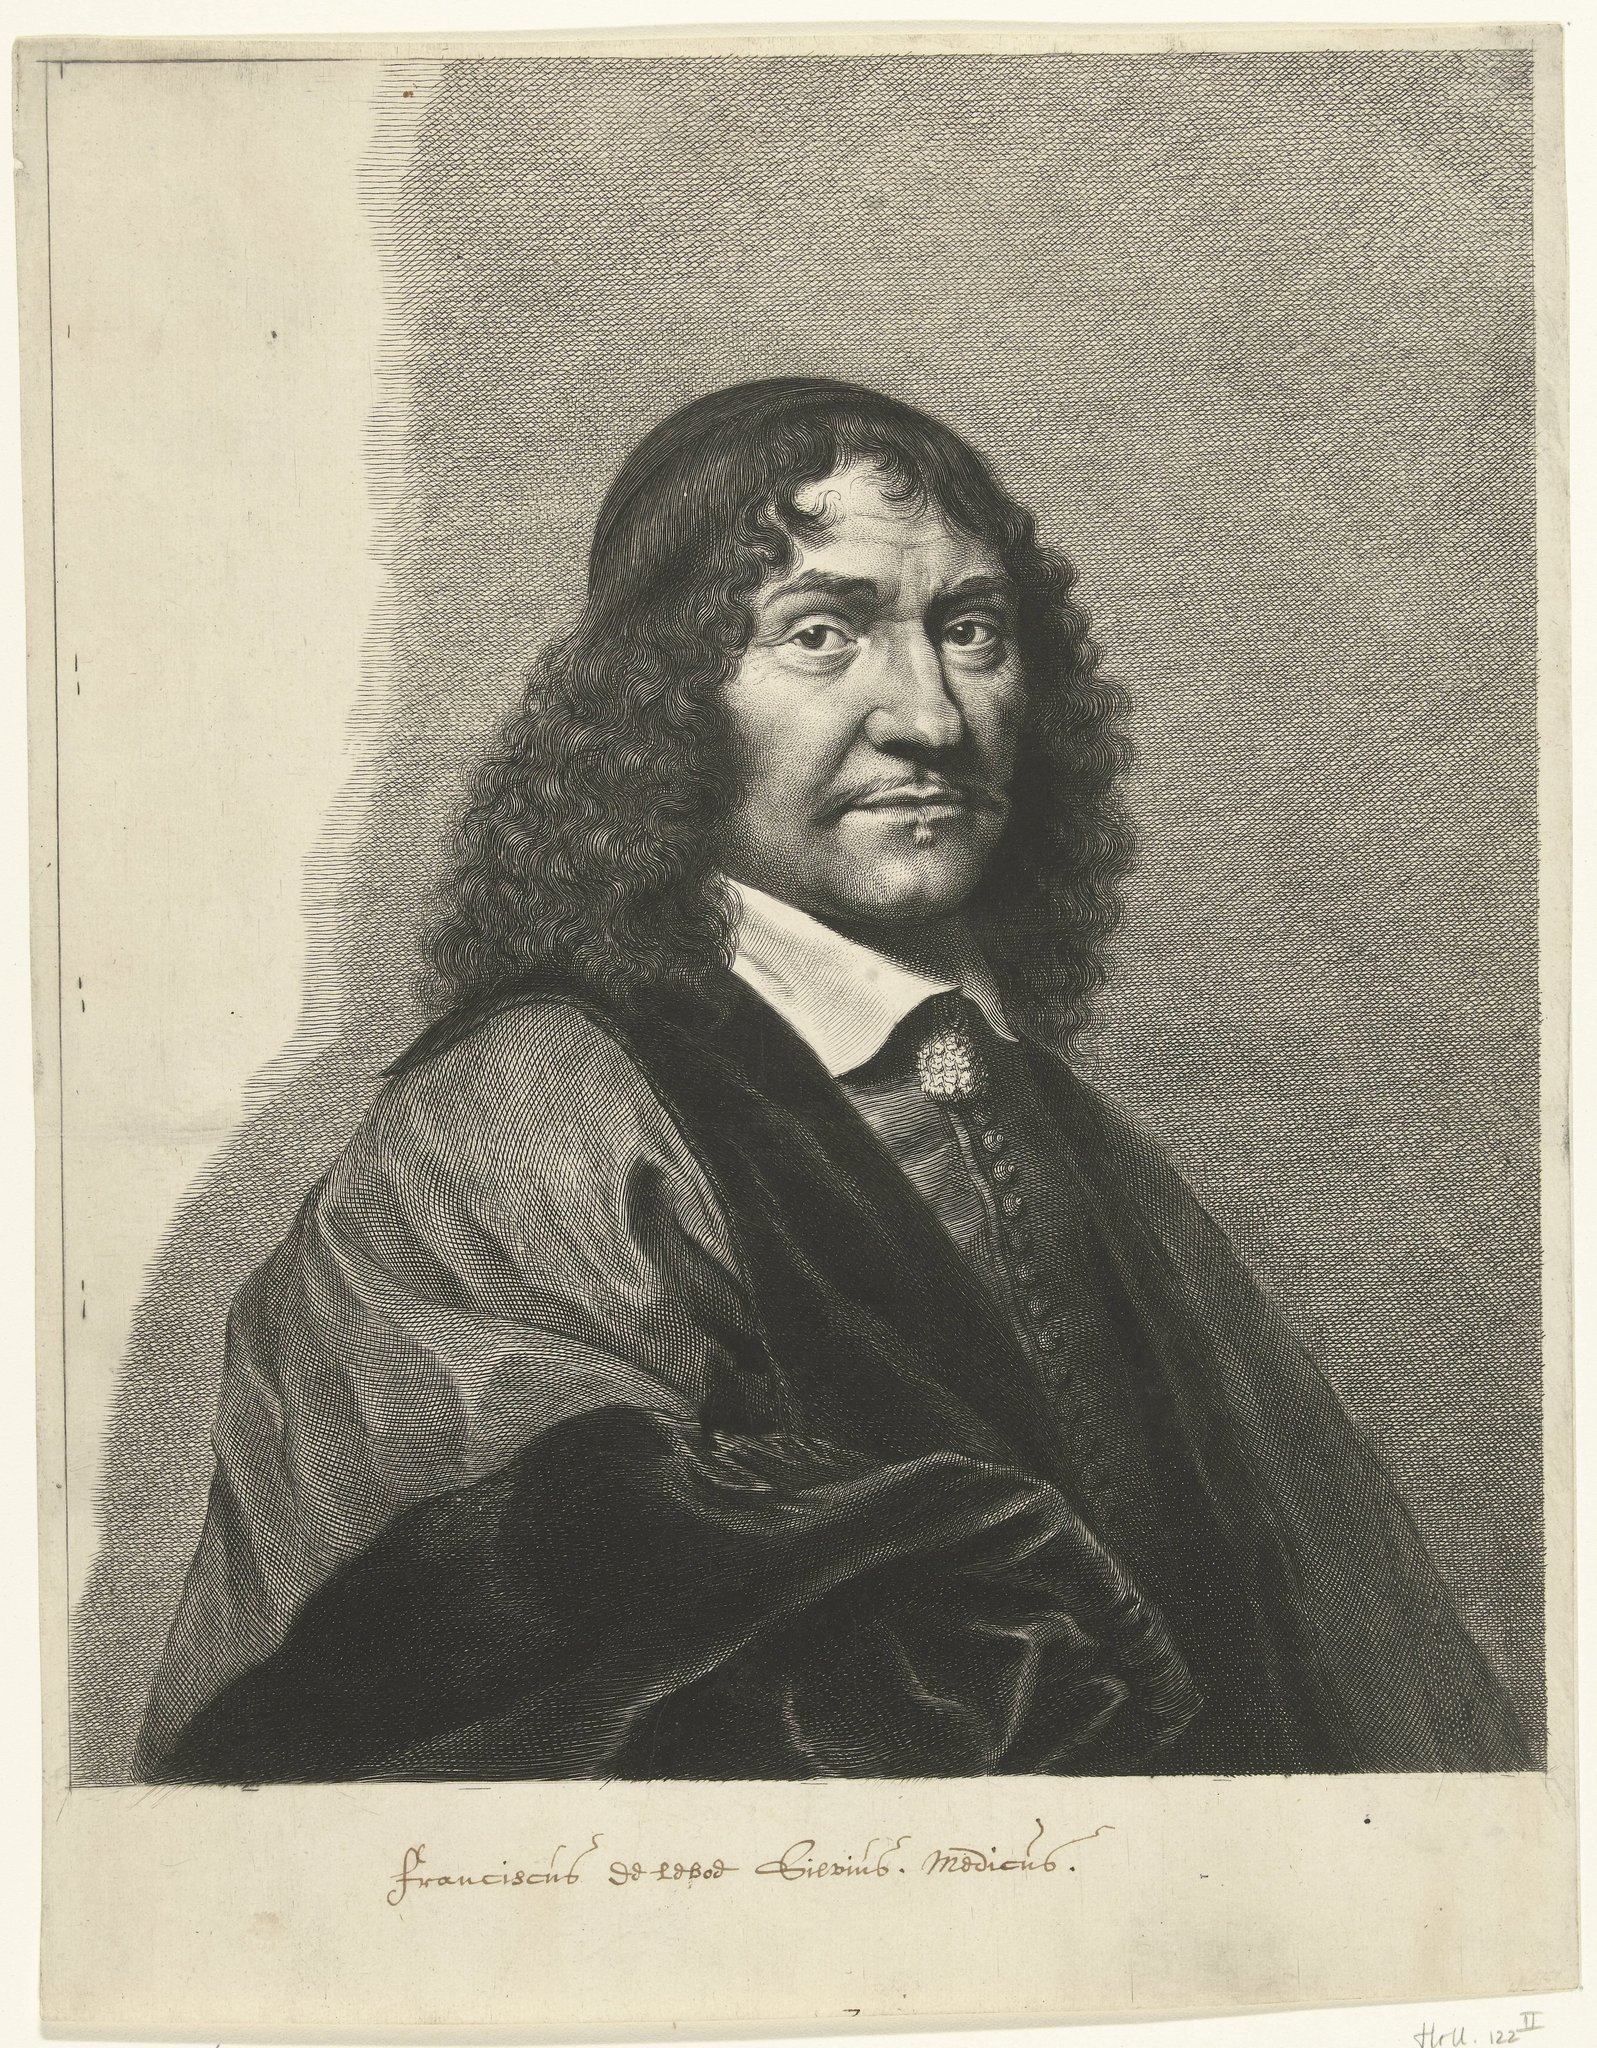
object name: print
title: Portret van Franciscus de le Boë Sylvius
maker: cornelis van dalen (ii)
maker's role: draughtsman, print maker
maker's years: 1638-1664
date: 1659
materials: paper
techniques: engraving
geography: amsterdam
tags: leiden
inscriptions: inscription: ‘Franciscus deleboe Silvius medicus’, collector's mark: Lugt 240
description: Portret van medicus Franciscus de le Boë Sylvius, borststuk.